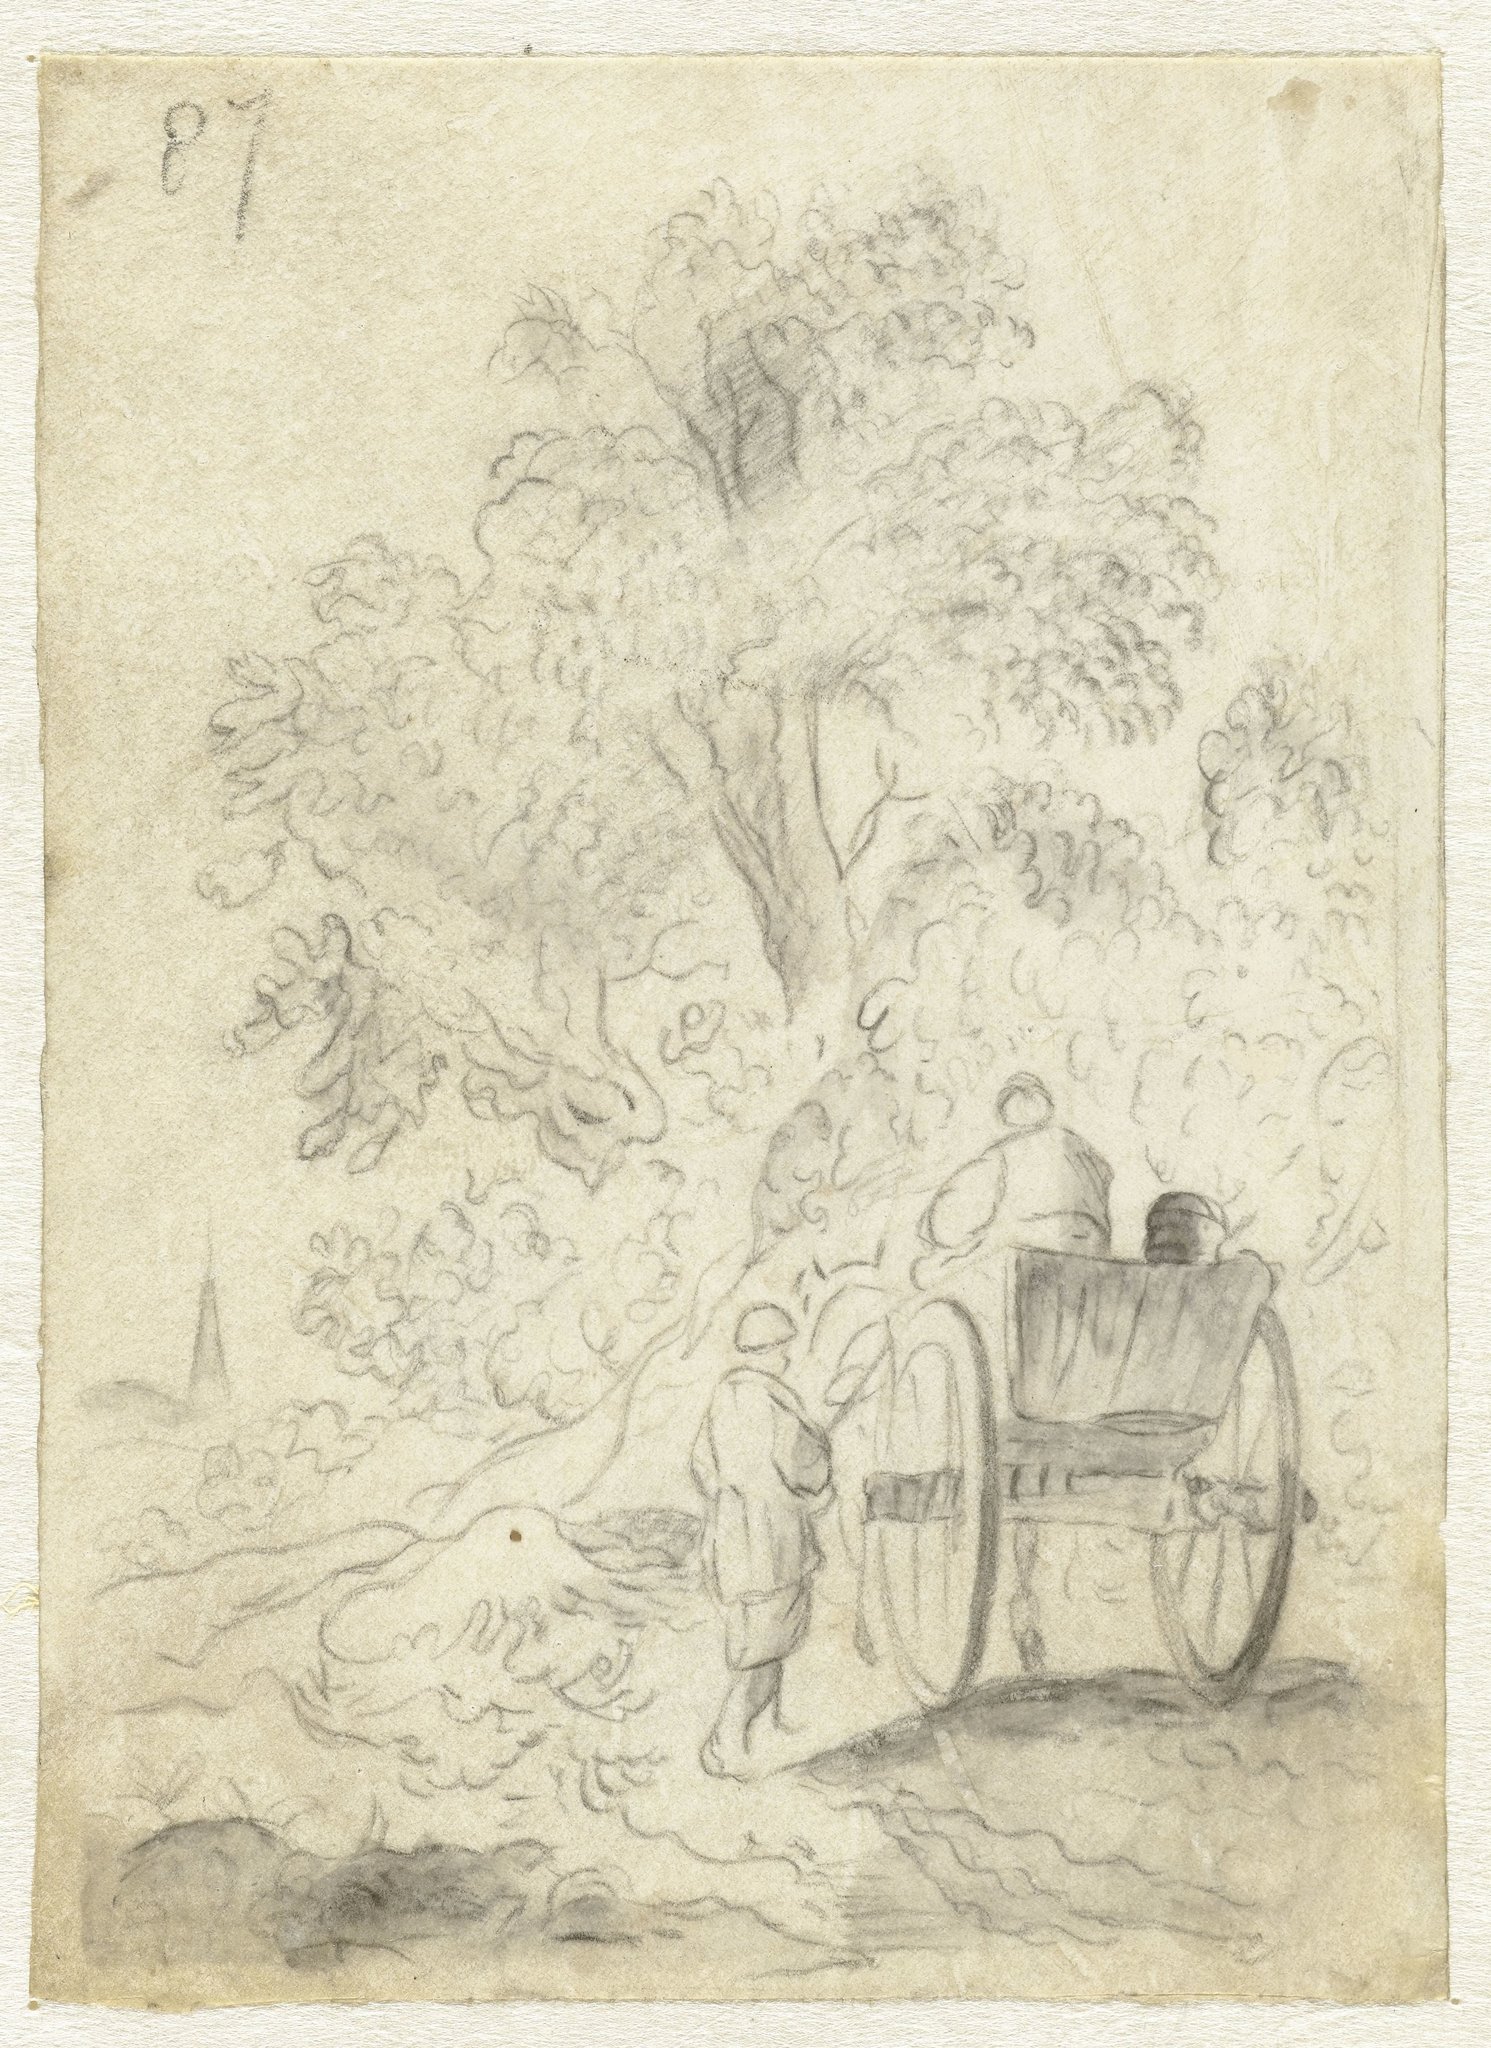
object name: drawing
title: Kar met twee figuren op een landweg langs een bos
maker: pieter de molijn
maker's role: draughtsman, painter, print maker, publisher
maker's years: 1595-1661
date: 1610-1660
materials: graphite, parchment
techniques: brush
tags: forest, wood, (farm) wagon, freight wagon, cart